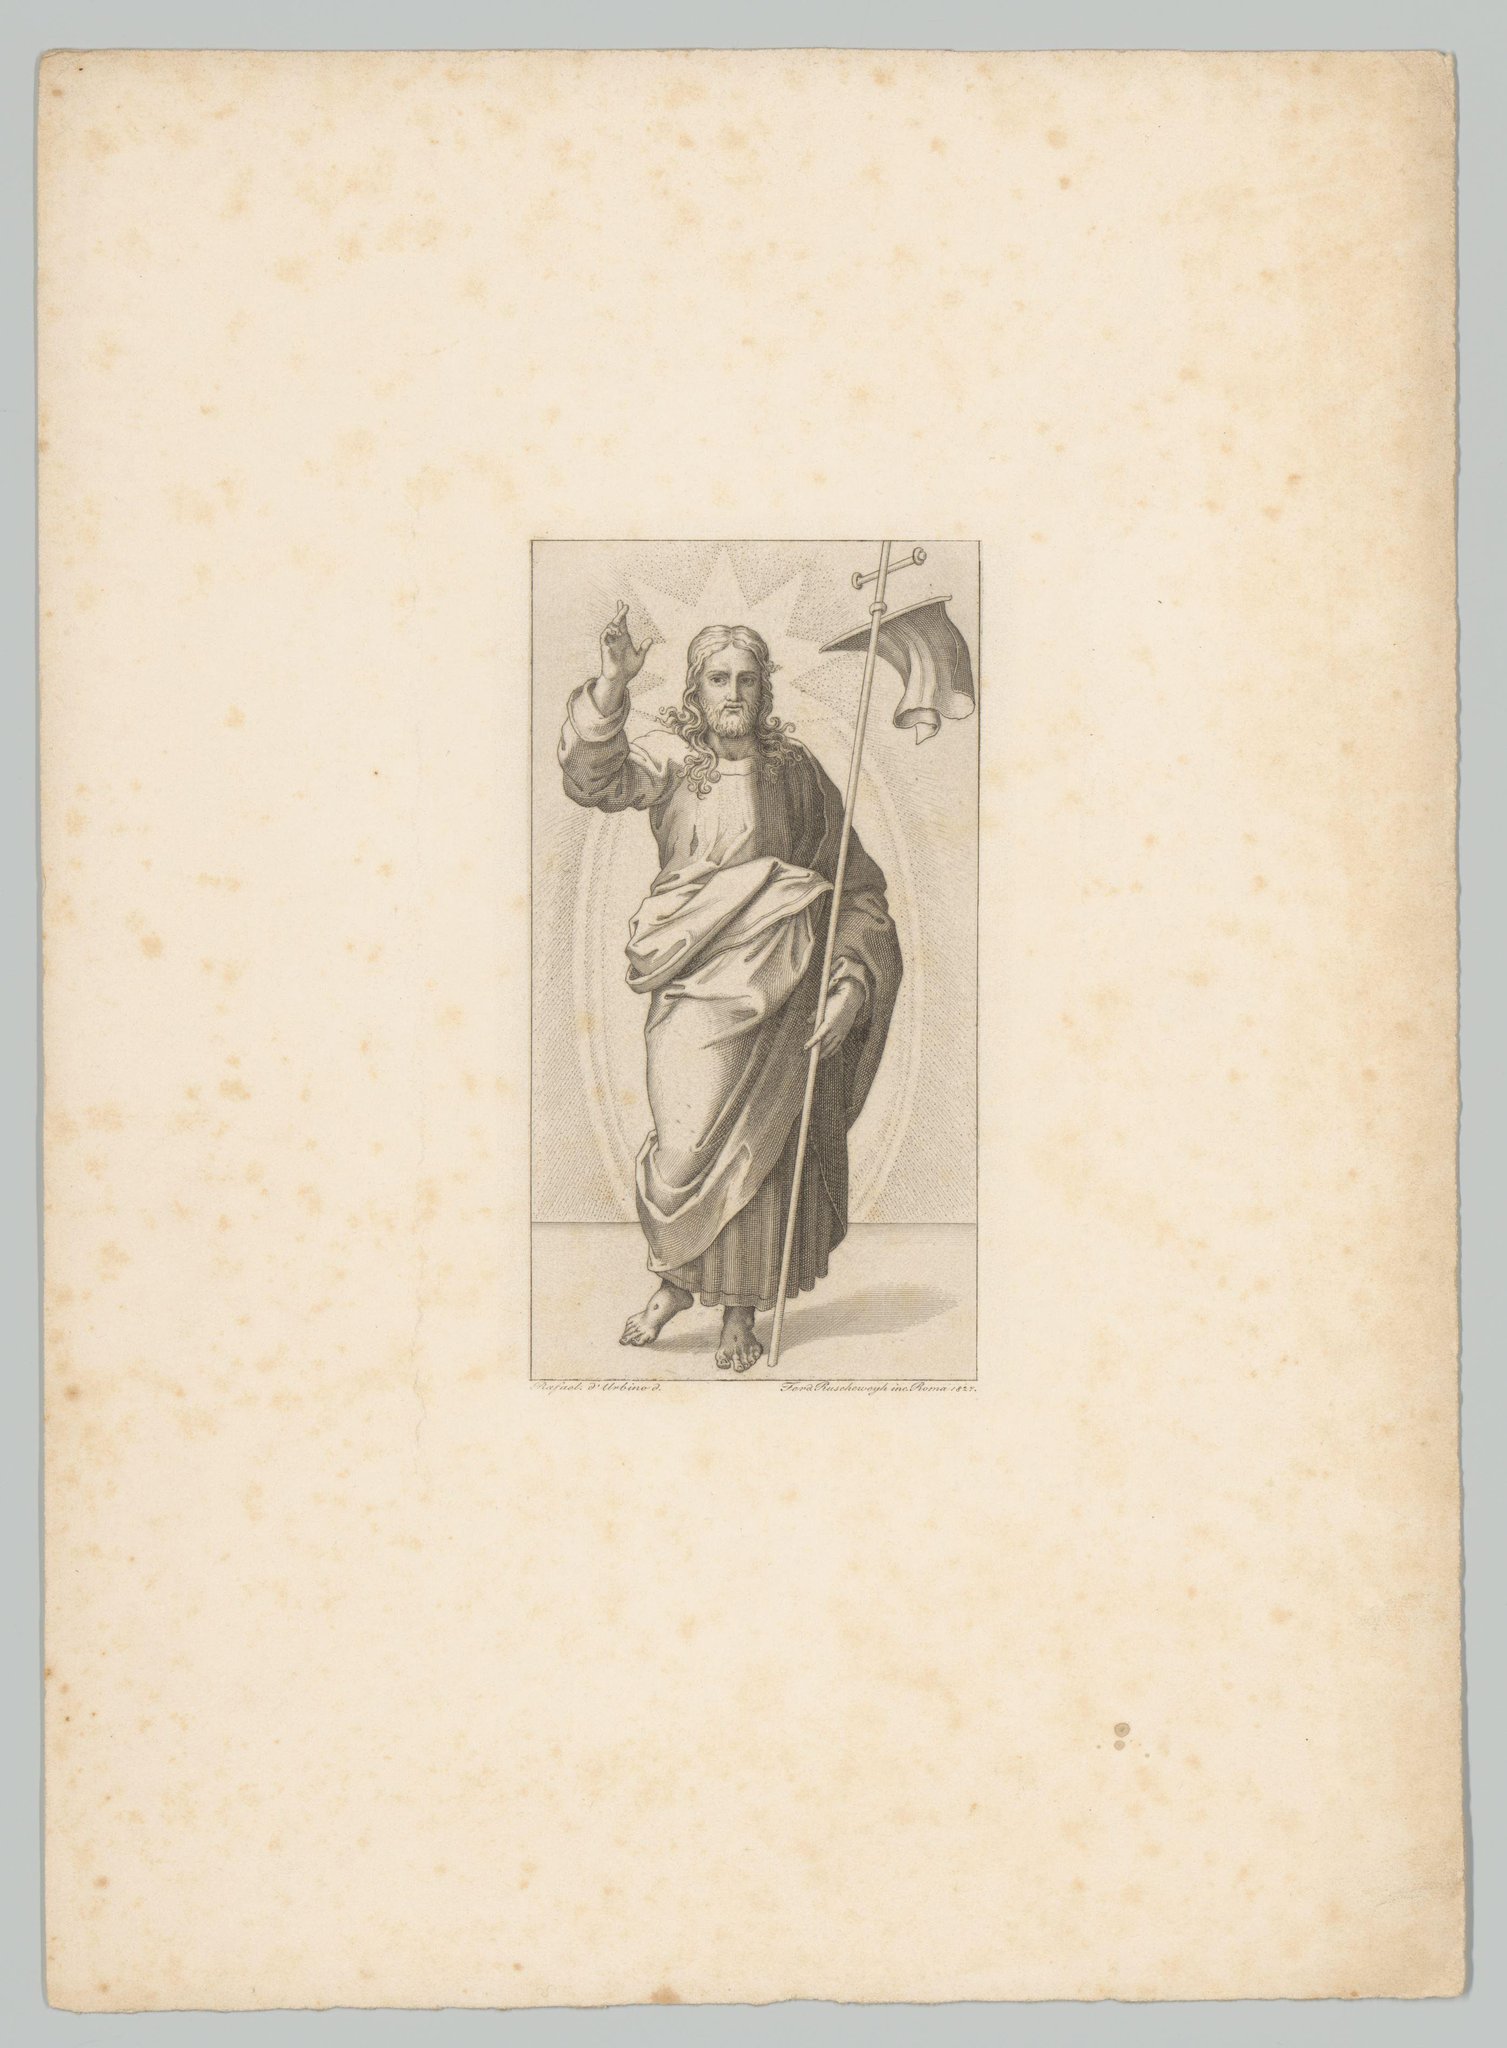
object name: print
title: Il Salvatore co'dodici Apostoli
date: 1827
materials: paper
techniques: etching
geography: rome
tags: adult christ together with apostles, evangelists, saints, etc., the twelve apostles (as a group), usually with books or scrolls (not in biblical context)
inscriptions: date